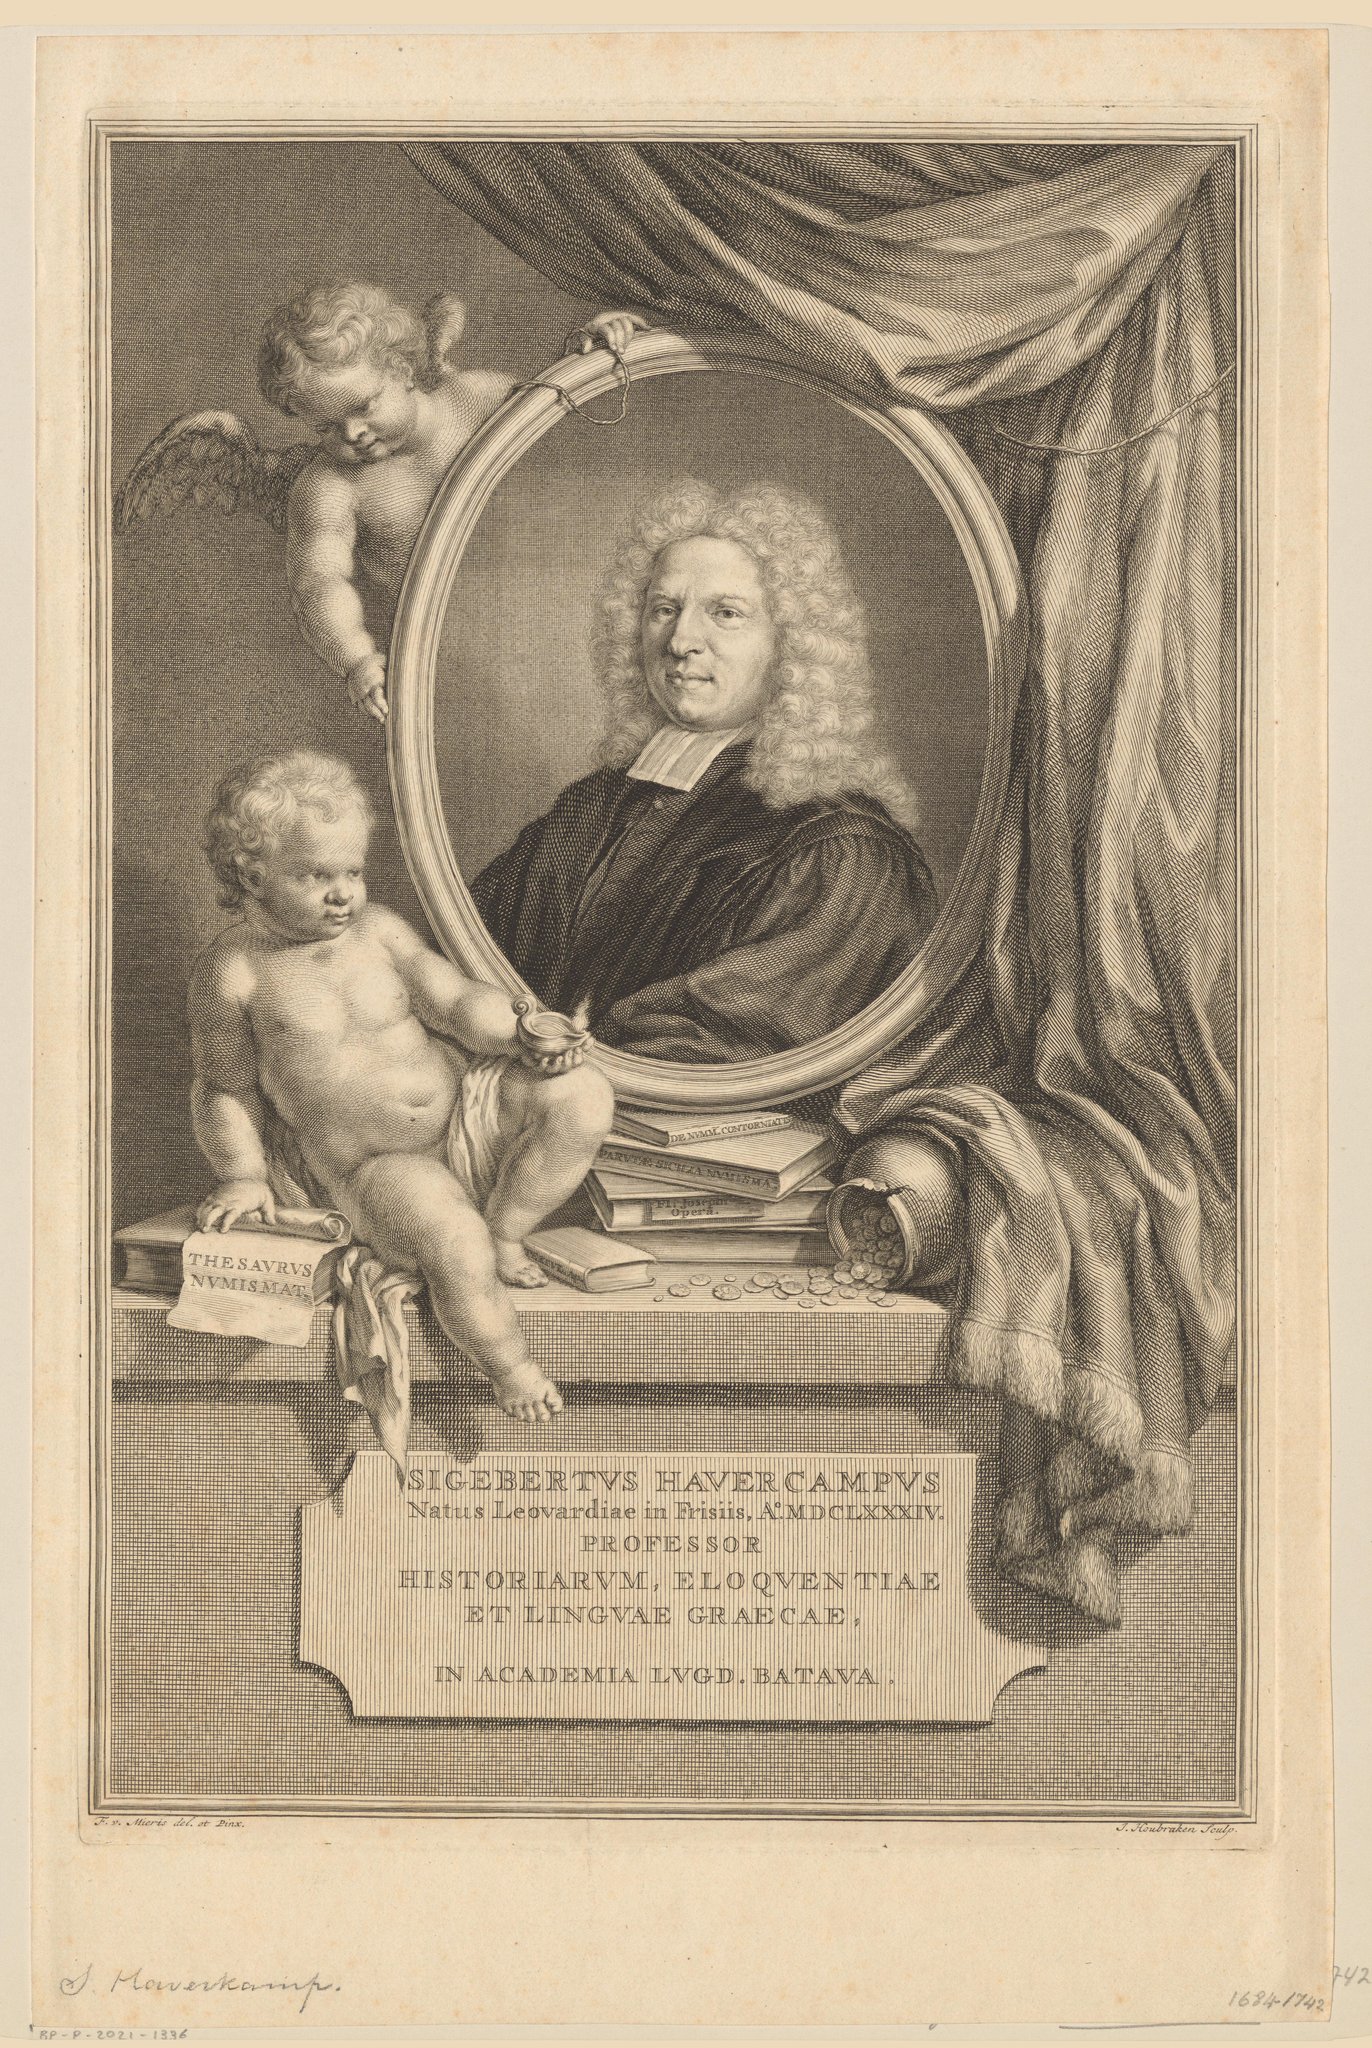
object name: print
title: Portret van Siwert Haverkamp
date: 1732-1780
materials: paper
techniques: engraving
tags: leiden, historical persons, portrait of a writer, book, cupids: 'amores', 'amoretti', 'putti'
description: Één van de boeken op de prent verwijst naar: Josephus, Flavius en Siwert Havercamp. Alle de werken. Amsterdam: Marten Schagen, 1732.